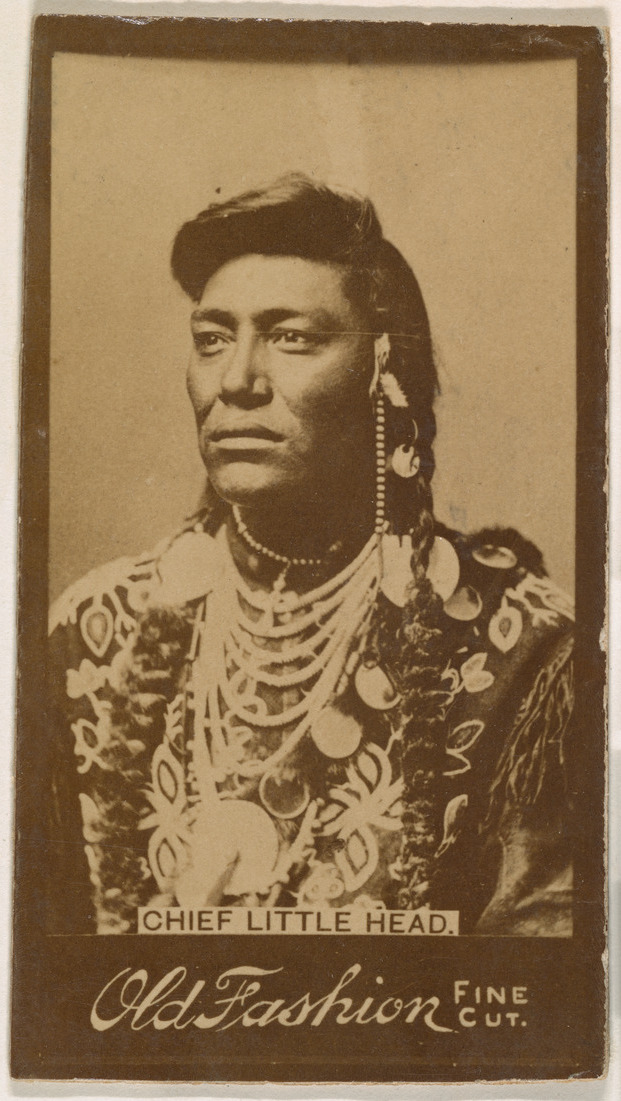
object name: photograph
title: Chief Little Head, from the Indian Chiefs series (N681) promoting Old Fashion Fine Cut Tobacco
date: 1888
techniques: albumen silver print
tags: men,portraits